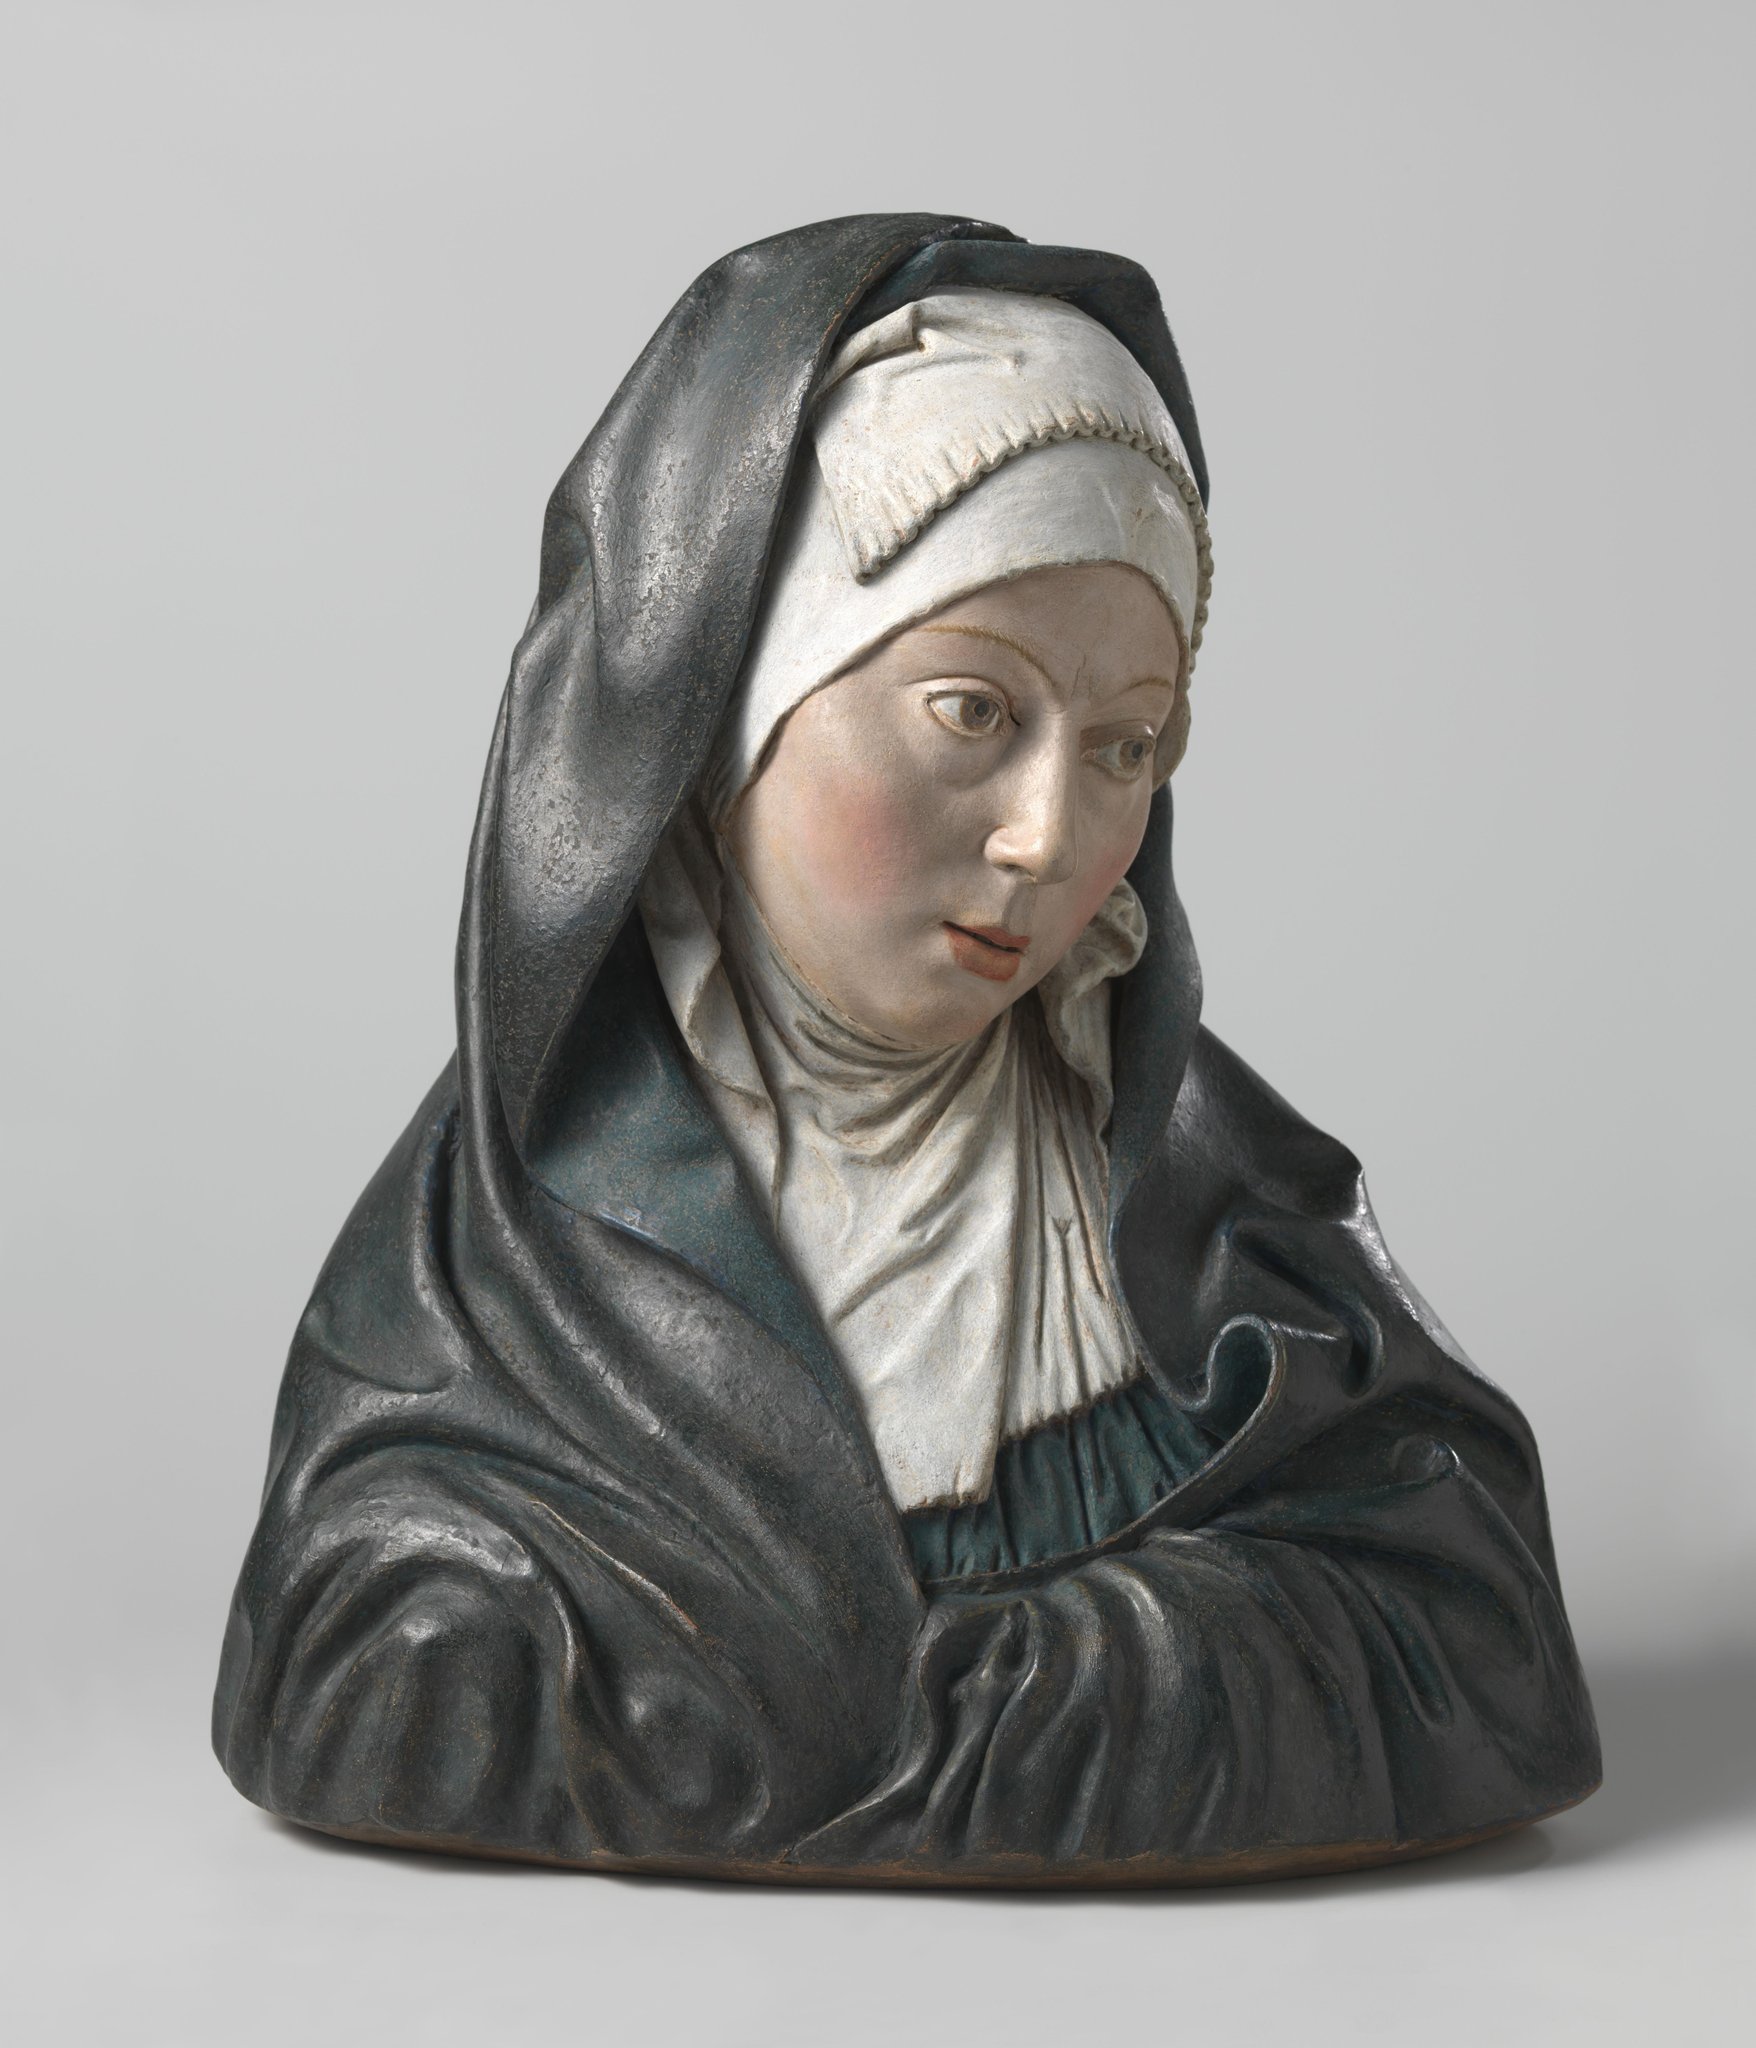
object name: bust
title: The Virgin as Mater Dolorosa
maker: pietro torrigiani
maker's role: sculptor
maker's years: 1472-1528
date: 1507-1510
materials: oil, terracotta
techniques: firing, molding, polychromy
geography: southern netherlands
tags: 'mater dolorosa' - ff - 'mater dolorosa', head or bust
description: This poignant bust of the Virgin, lamenting the death of her son, Jesus, was probably made by Pietro Torrigiani, an Italian living in Bruges, where he was in the service of Archduchess Margaret of Austria. For Margaret, herself a grieving widow, the theme of Mary’s mourning had great resonance. The figure’s lifelike appearance made it easier to identify with the Virgin’s sorrow.